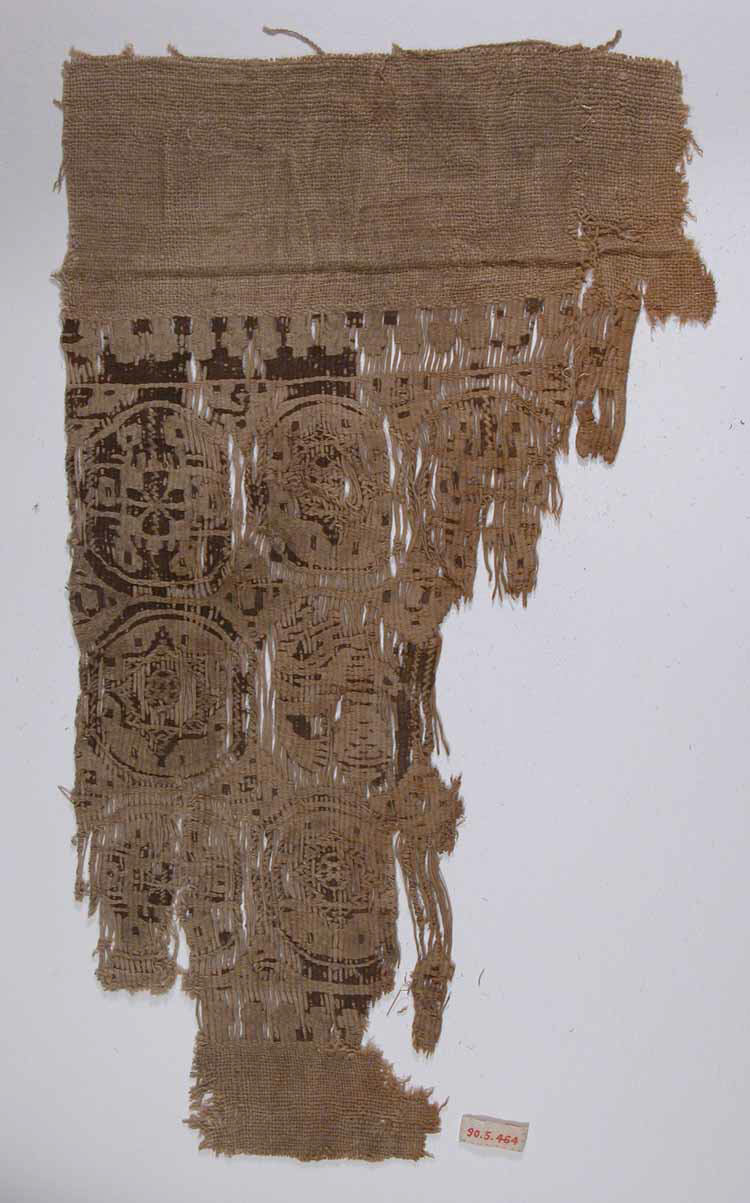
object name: textile fragment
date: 301-400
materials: linen, wool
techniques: weave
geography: egypt